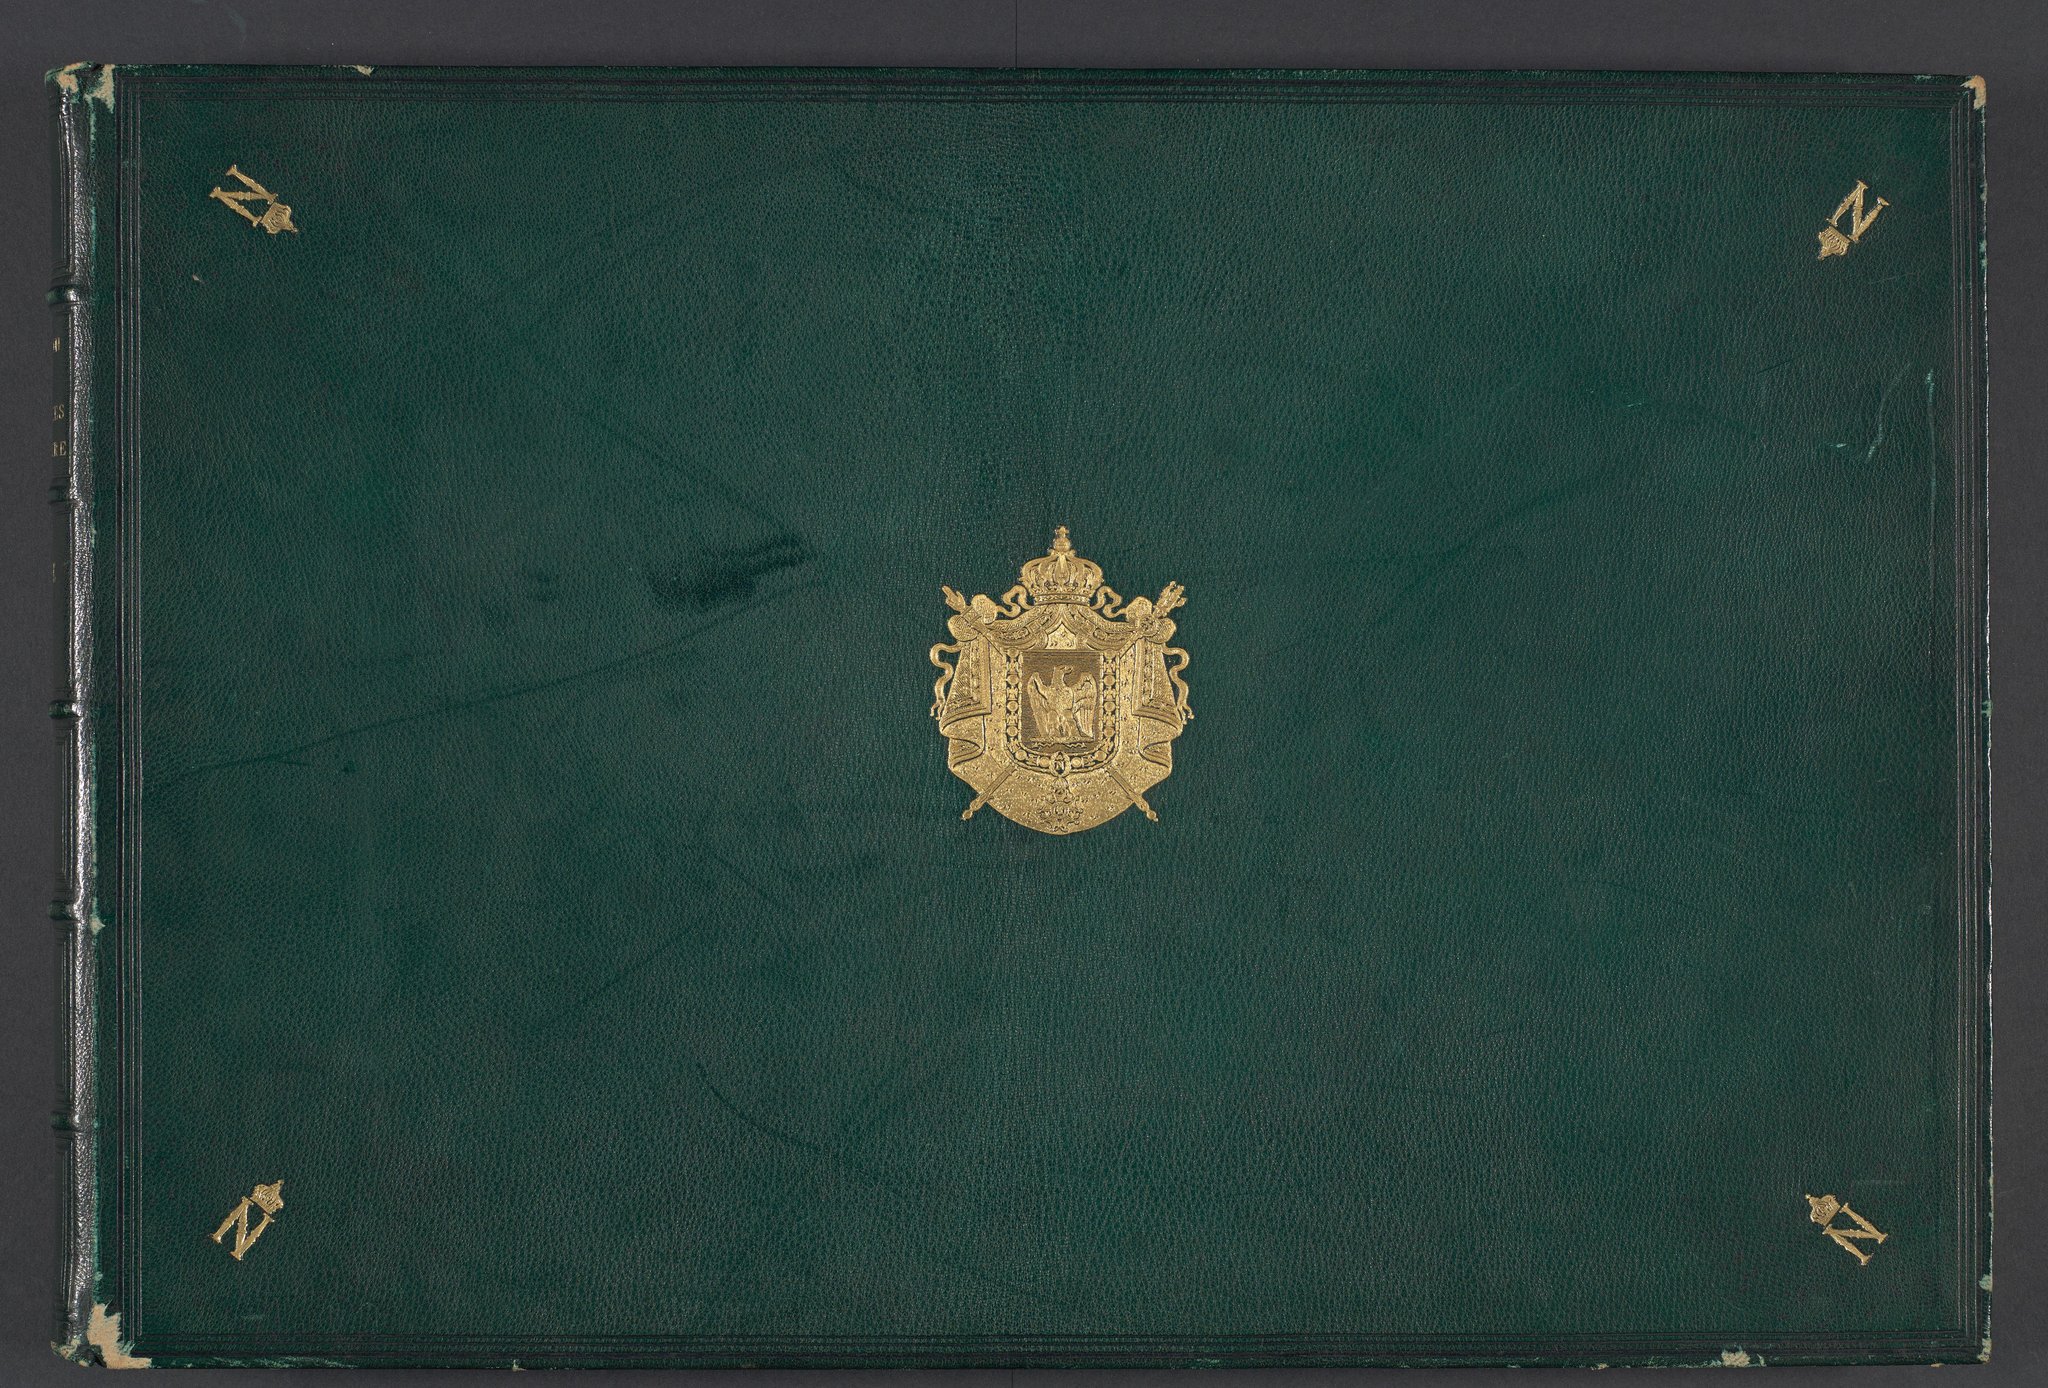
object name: photograph album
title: Réunion des Tuileries au Louvre 1852-1857. Recueil de photographies publié par ordre de s. exc. mr. Achille Fould, ministre d'état et de la maison de l'empereur.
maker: édouard denis baldus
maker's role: fotograaf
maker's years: 1813-1889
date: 1854-1857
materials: cardboard, leather, paper, photographic support, textile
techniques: engraving, salted paper print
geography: paris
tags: permanent exhibition, museum, paris, tuileries palace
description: Fotoalbum in groen leren omslag. Op de voor- en achterzijde prijkt het wapenschild van de Franse keizer Napoleon III, in de hoeken zijn monogram. Op de rugband wordt de titel vermeld en het deelnummer. De schutbladen zijn van groen changeant met een randversiering van Franse lelies in gouddruk. Het album bevat 76 bladen met goud op snee die elk één tot drie foto's bevatten. Het album maakt deel uit van een ensemble van vier waarmee de bouw van het nieuwe Louvre tussen 1854 en 1857 stap voor stap werd gedocumenteerd in opdracht van de Franse regering. De albums werden als representatie-exemplaren aangeboden aan de keizer, bevriende staatshoofden, ministers (zoals het exemplaar van het Rijksmuseum) en bibliotheken. Er werden 36 van dergelijke sets samengesteld, elk met ongeveer 550 foto's. Slechts vier ensembles zijn bewaard gebleven.